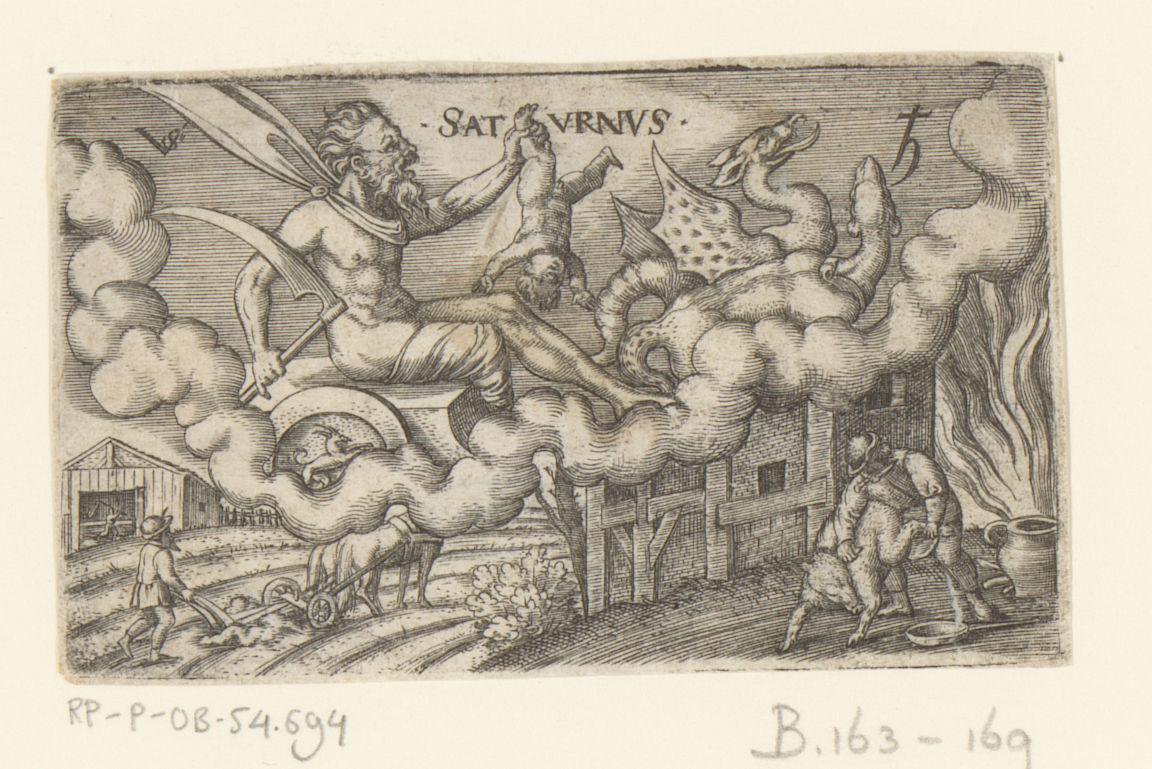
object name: print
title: Saturnus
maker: virgilius solis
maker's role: draughtsman, print maker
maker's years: 1514-1562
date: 1524-1562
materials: paper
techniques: engraving, etching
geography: nuremberg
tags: (story of) saturn (cronus), clouds, chariot, triumphal car, saturn (planet)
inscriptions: collector's mark: Lugt 2228, number: ‘53’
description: Maakt deel uit van een serie van zeven prenten met personificaties van de planeten op triomfwagens.